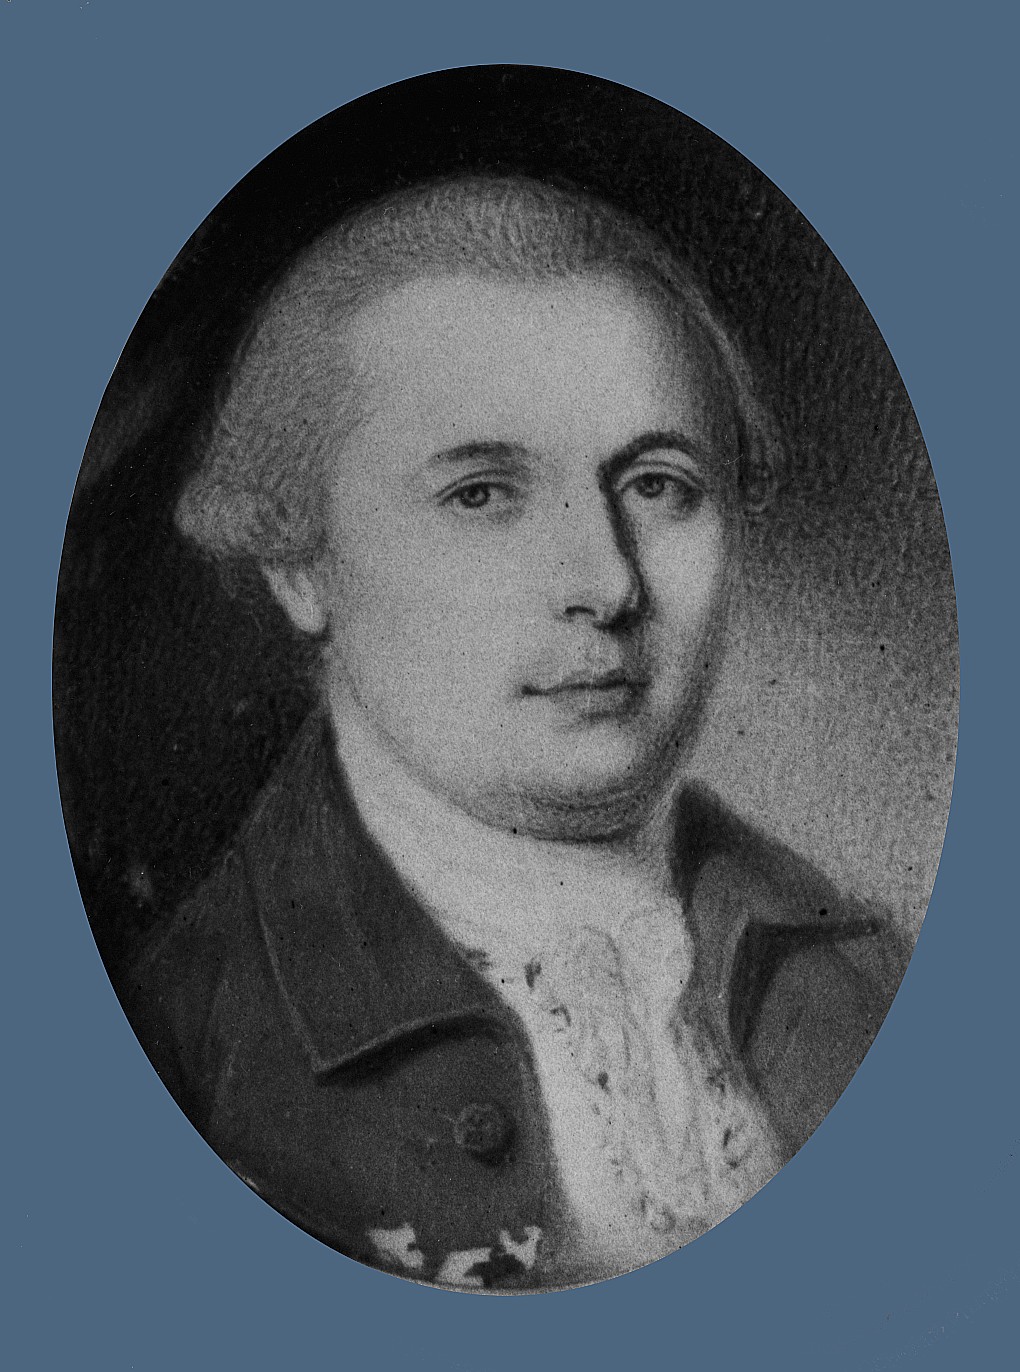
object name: painting, miniature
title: Nathanael Greene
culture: american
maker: charles willson peale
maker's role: artist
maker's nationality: american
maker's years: 1741-1827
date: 1778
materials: ivory, watercolor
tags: men,portraits